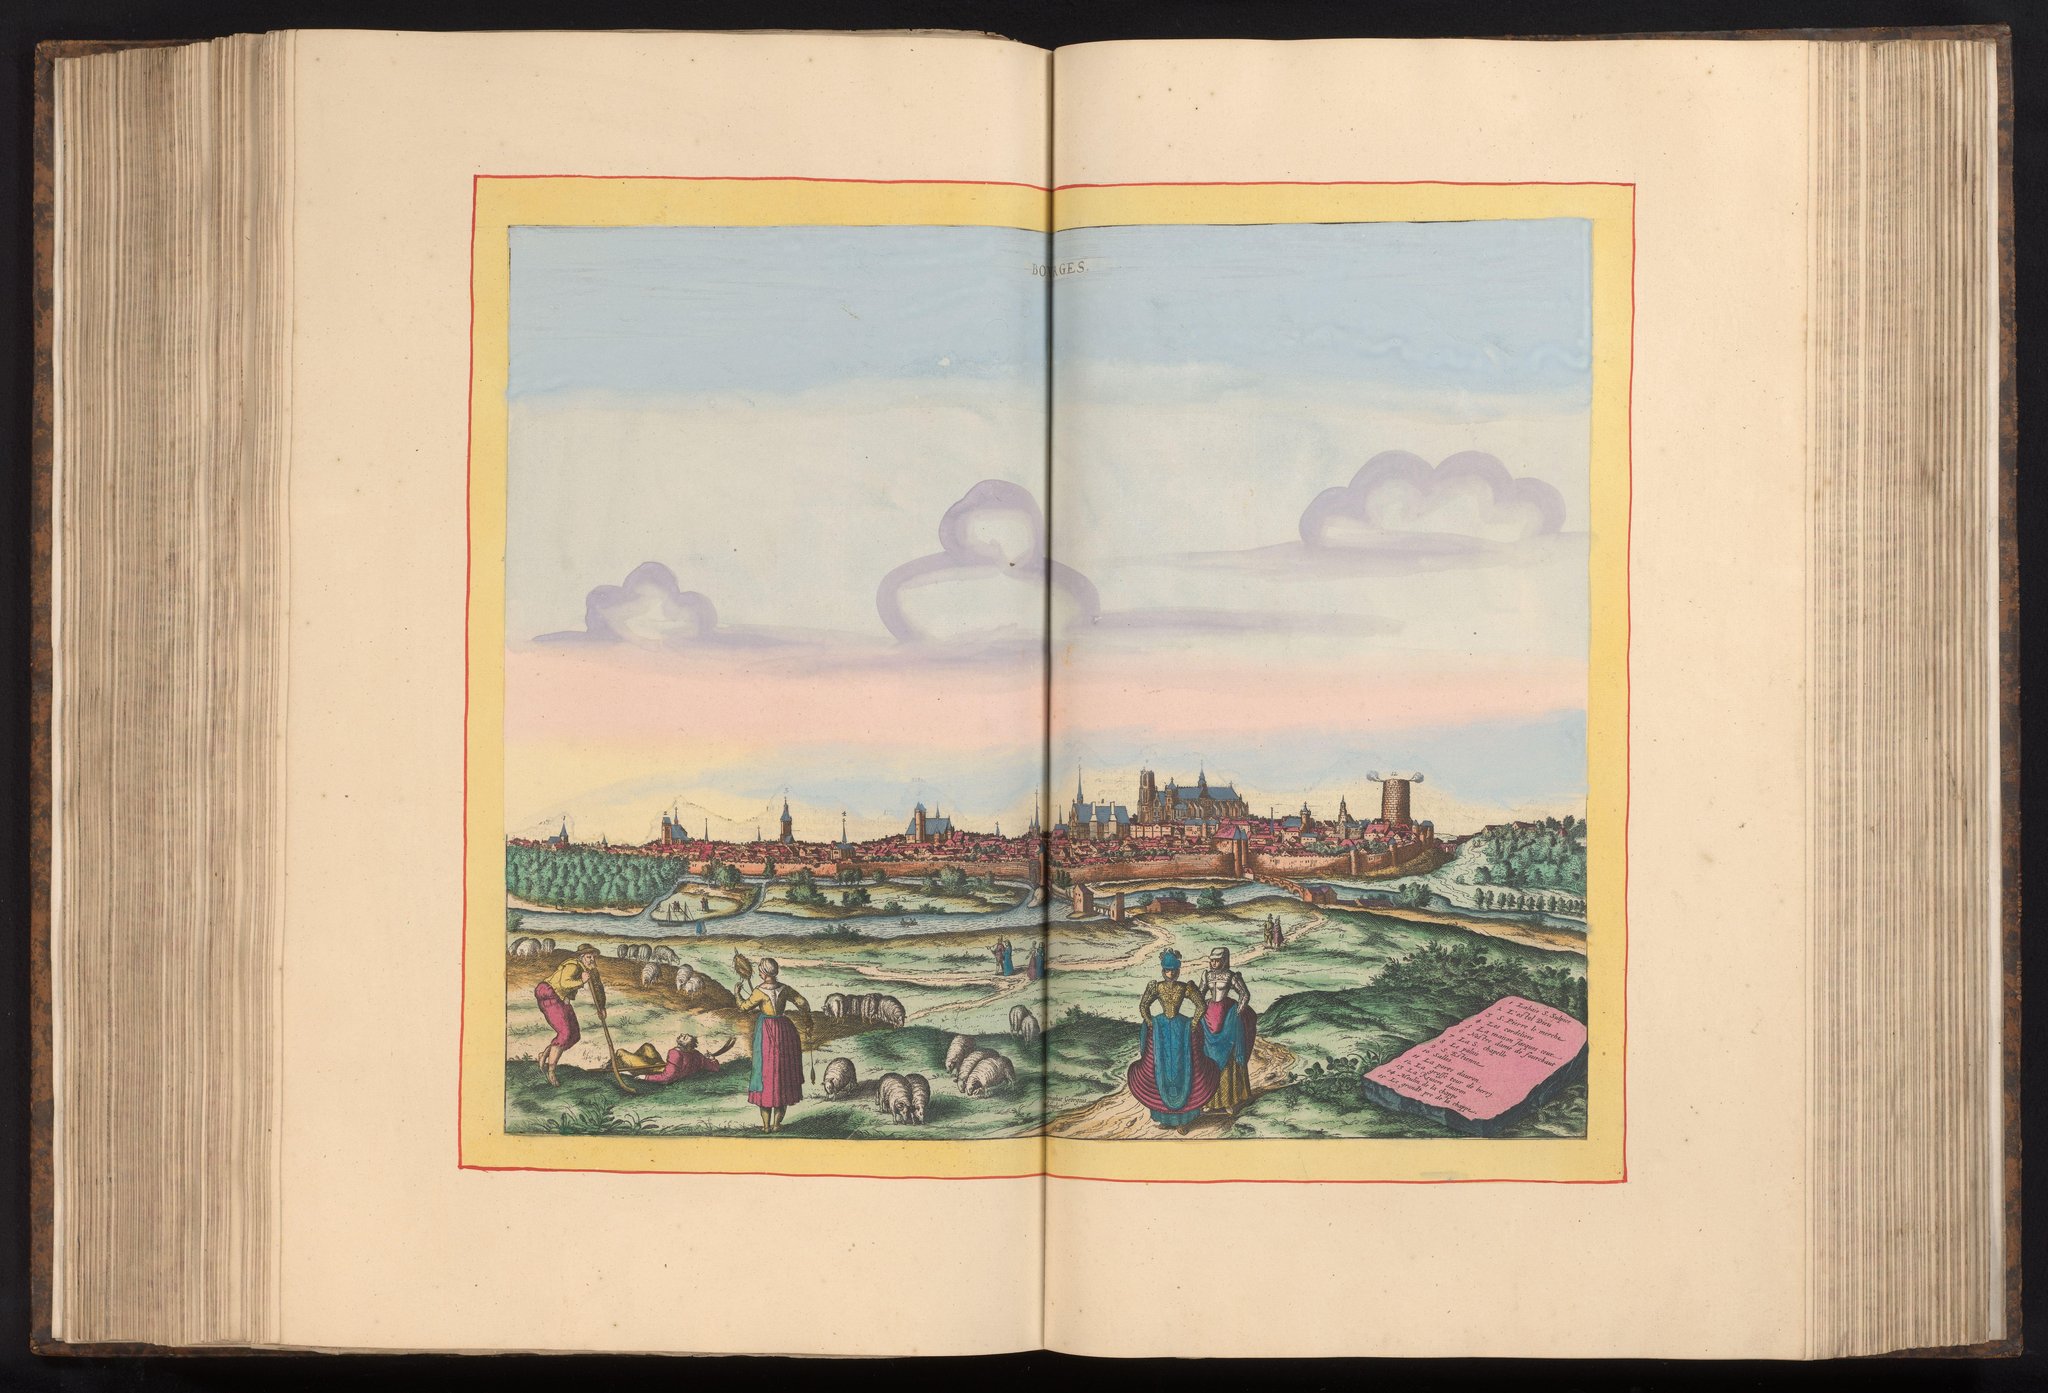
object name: album leaf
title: Gezicht op Bourges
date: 1575-1657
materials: paper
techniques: engraving, hand coloring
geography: the hague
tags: city-view in general; 'veduta'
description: Prent gebruikt in: Braun, Georg & Frans Hogenberg. Civitates orbis terrarum. S.l.s.n., 1575, en in: Theatrum exhibens celebriores Galliae et Helvetae urbes. Amsterdam: Johannes Janssonius, 1657. Origineel gedrukt op één blad met het gezicht op Orléans (RP-P-1956-210).